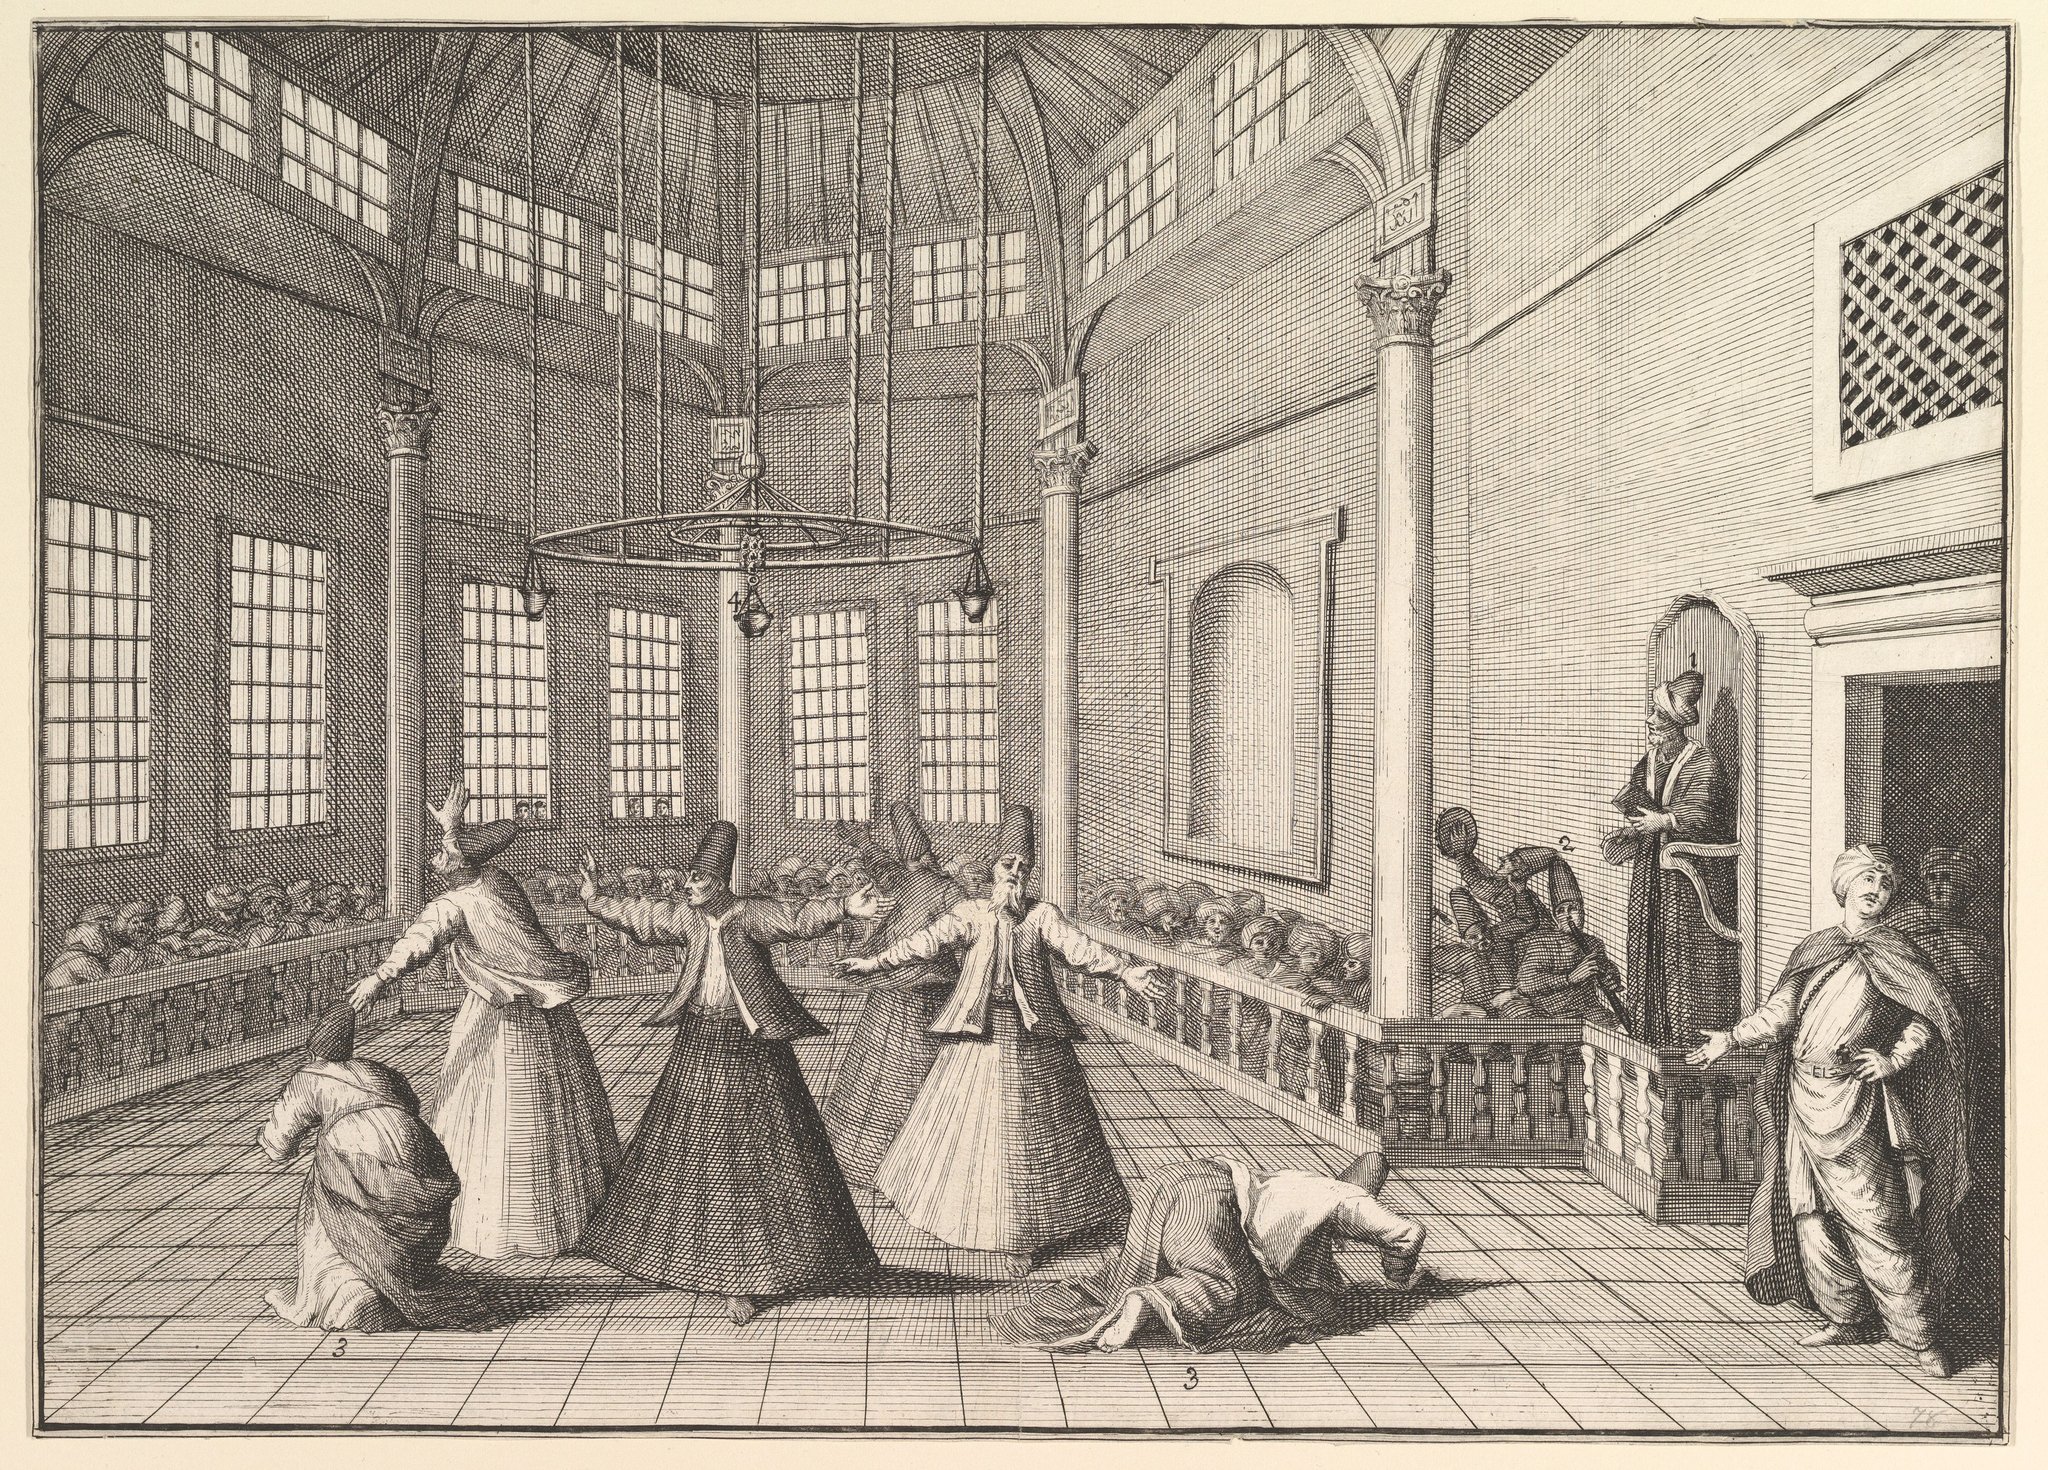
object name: print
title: The Inside of a Mosque, the Dervishes Dancing (Aubry de La Mottraye's "Travels throughout Europe, Asia and into Part of Africa...," London, 1724, vol. I, pl. 16)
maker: william hogarth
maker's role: artist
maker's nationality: british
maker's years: 1697-1764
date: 1723-1724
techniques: engraving, etching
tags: mosques,men,dancing,ceremony